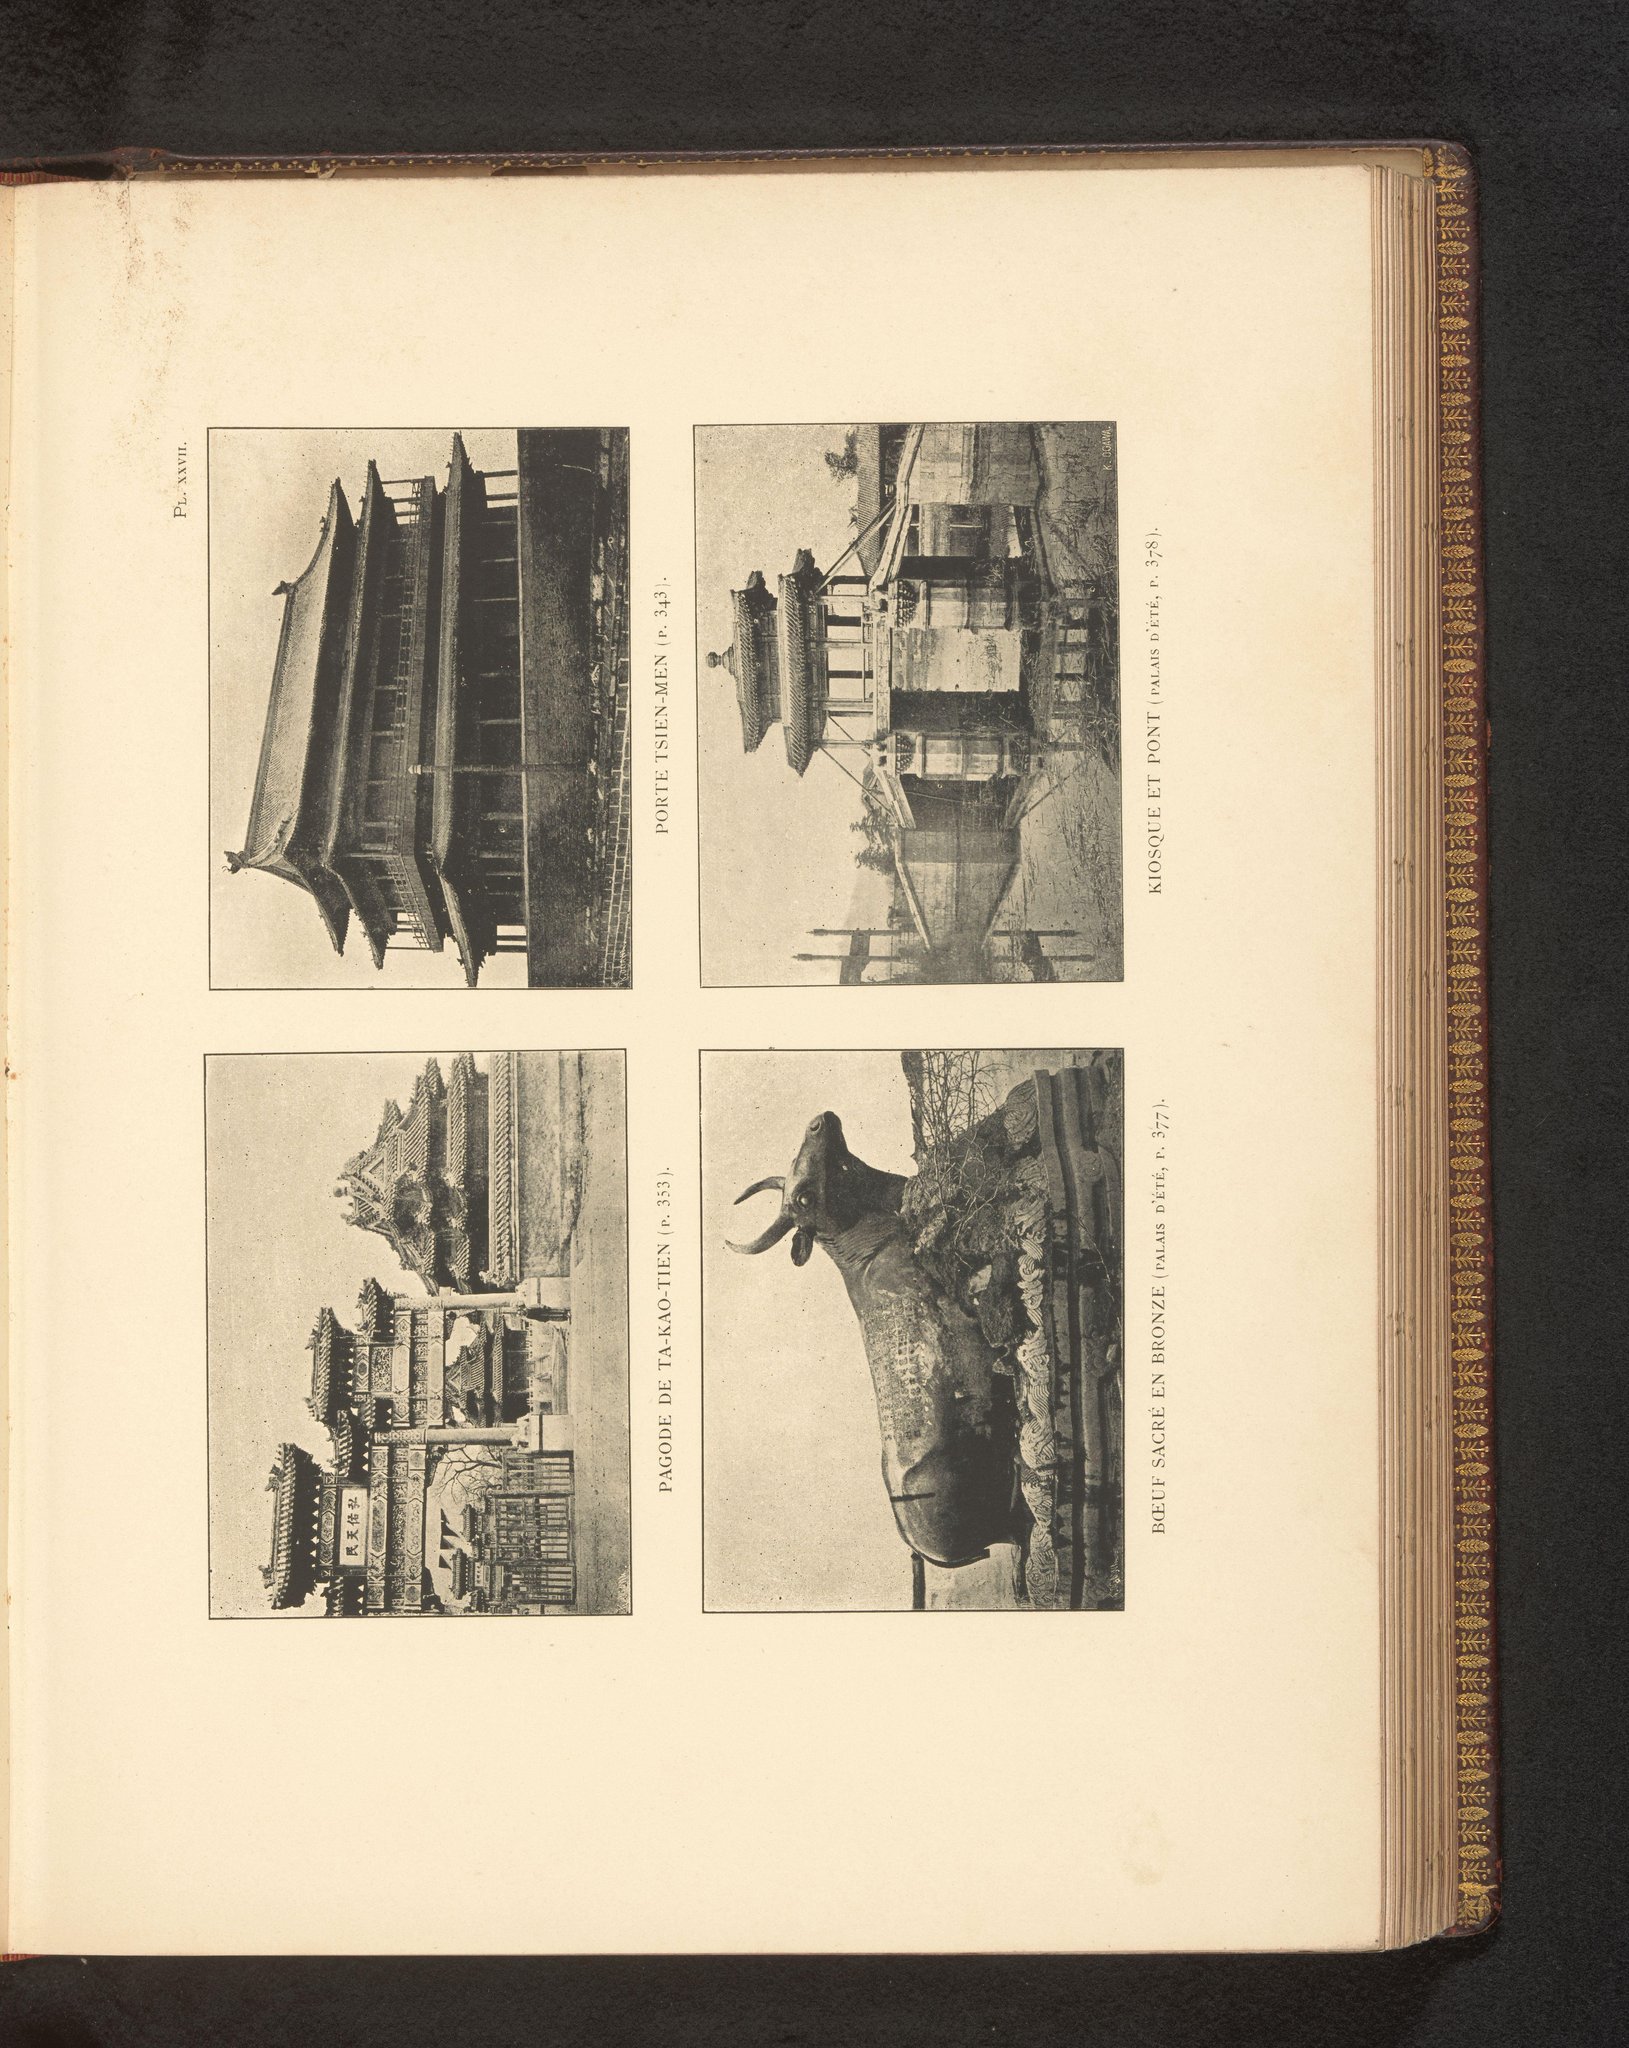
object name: page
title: Gezicht op een pagode, Gezicht op een pagode, Bronzen sculptuur van een koe bij het Zomerpaleis en Kiosk bij de brug bij het Zomerpaleis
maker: Anonymous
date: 1892-1897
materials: paper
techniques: autotype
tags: places and objects of worship ~ hinduism, buddhism, jainism, sculpture, bridge